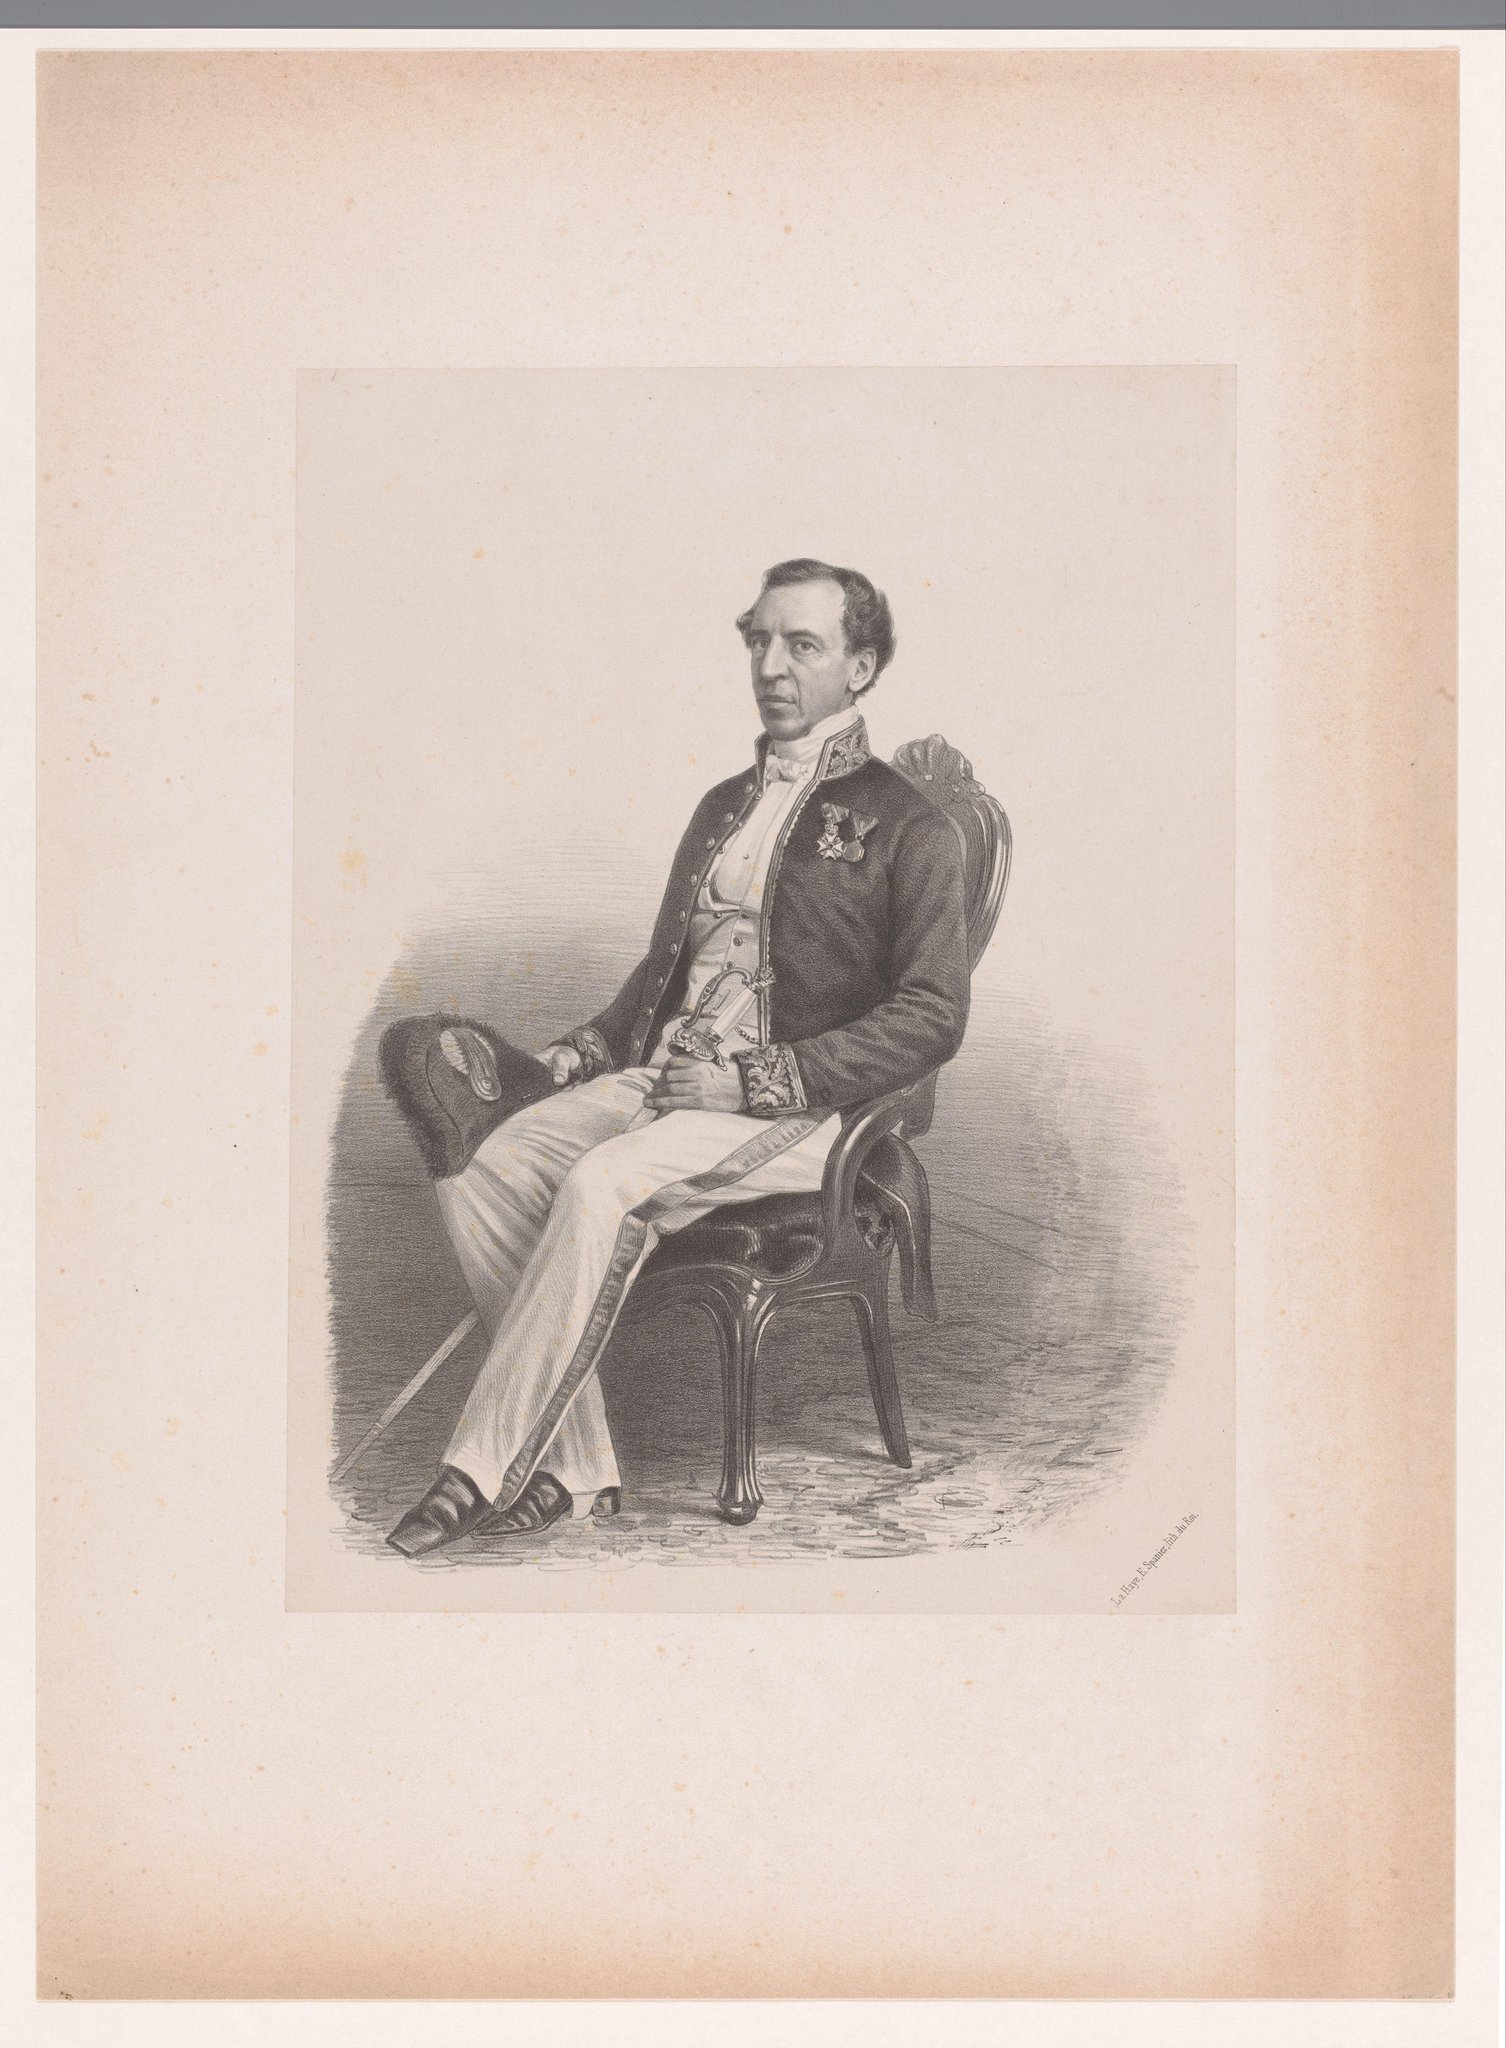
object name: print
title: Portret van onbekende man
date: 1831-1863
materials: paper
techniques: lithograph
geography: the hague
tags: anonymous historical person portrayed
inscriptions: collector's mark: Lugt 2228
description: Een man zittend op een stoel, ten voeten uit. In zijn handen houdt hij zijn steek en degen.